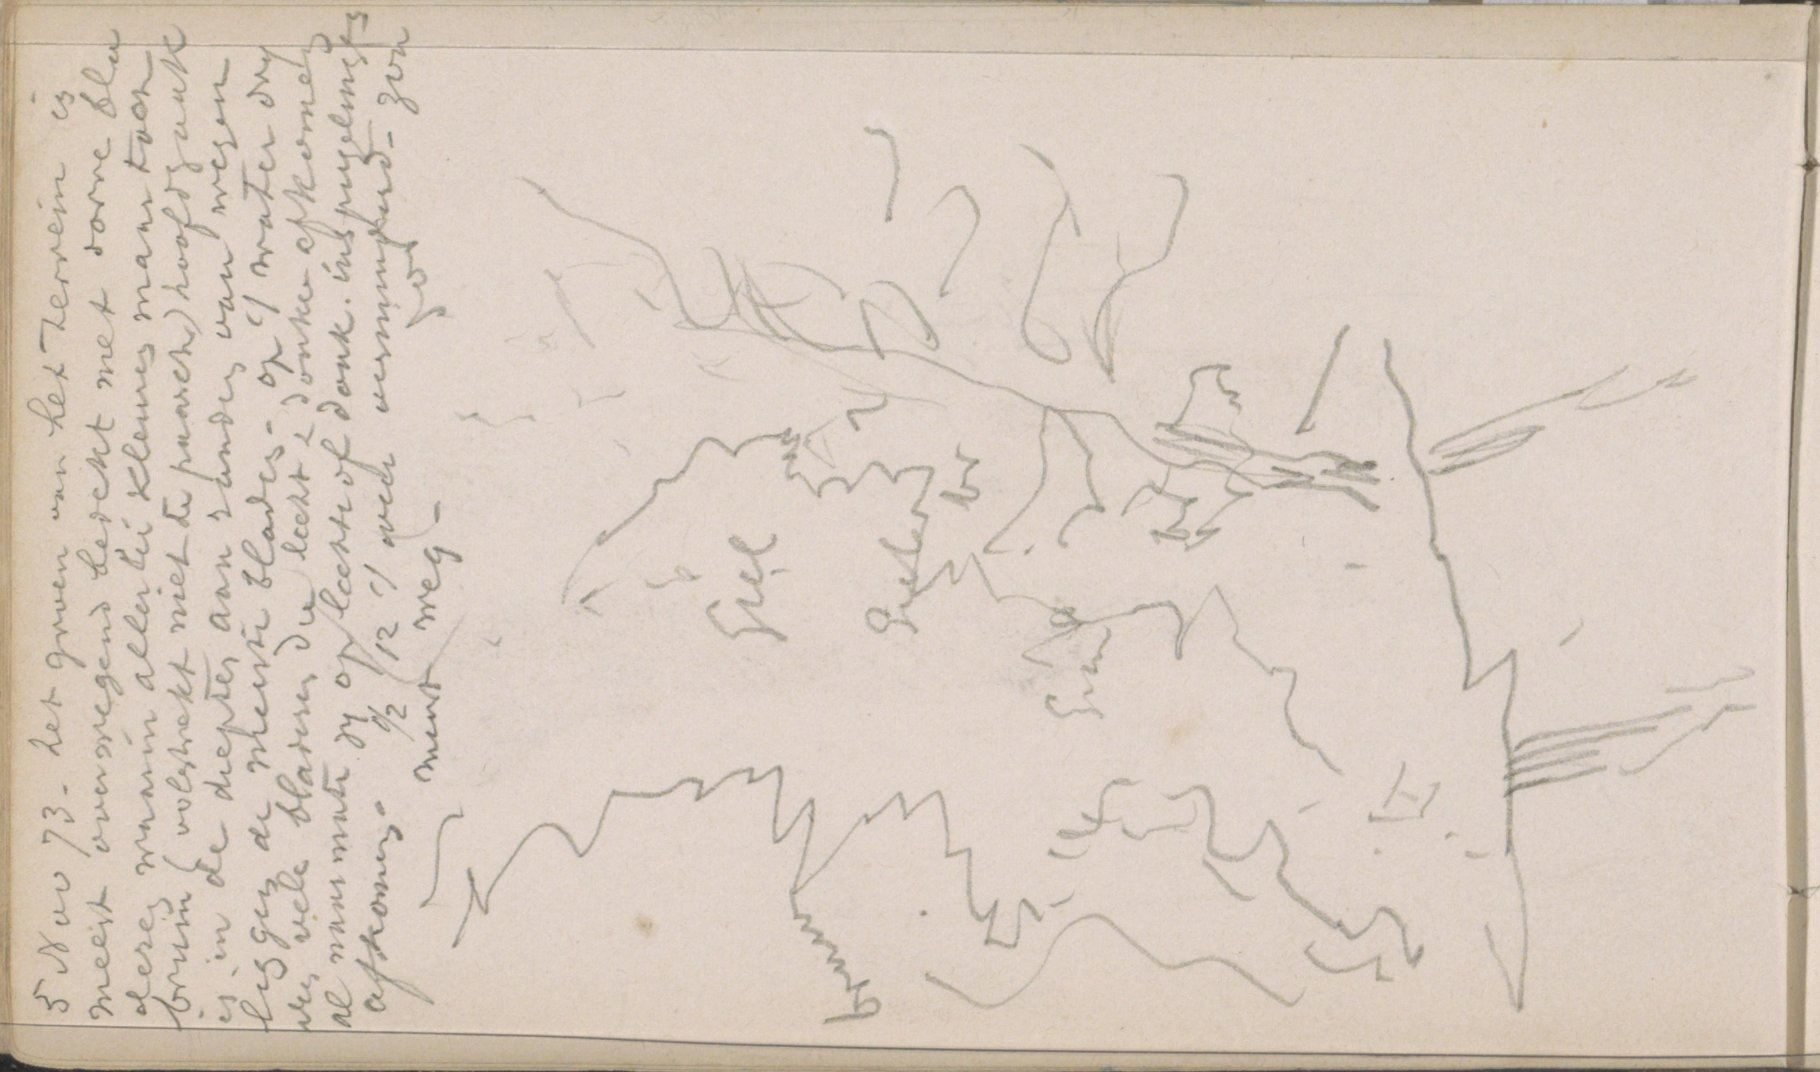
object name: sketchbook leaf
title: Haagse Bos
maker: johannes tavenraat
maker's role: draughtsman, painter, print maker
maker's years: 1809-1881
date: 1811-1873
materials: paper, pencil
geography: the hague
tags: forest, wood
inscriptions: date and inscription: ‘Haagsche Bosch/ 5. Nov. 73’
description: Blad 19 verso en 20 recto uit een schetsboek met 46 bladen.